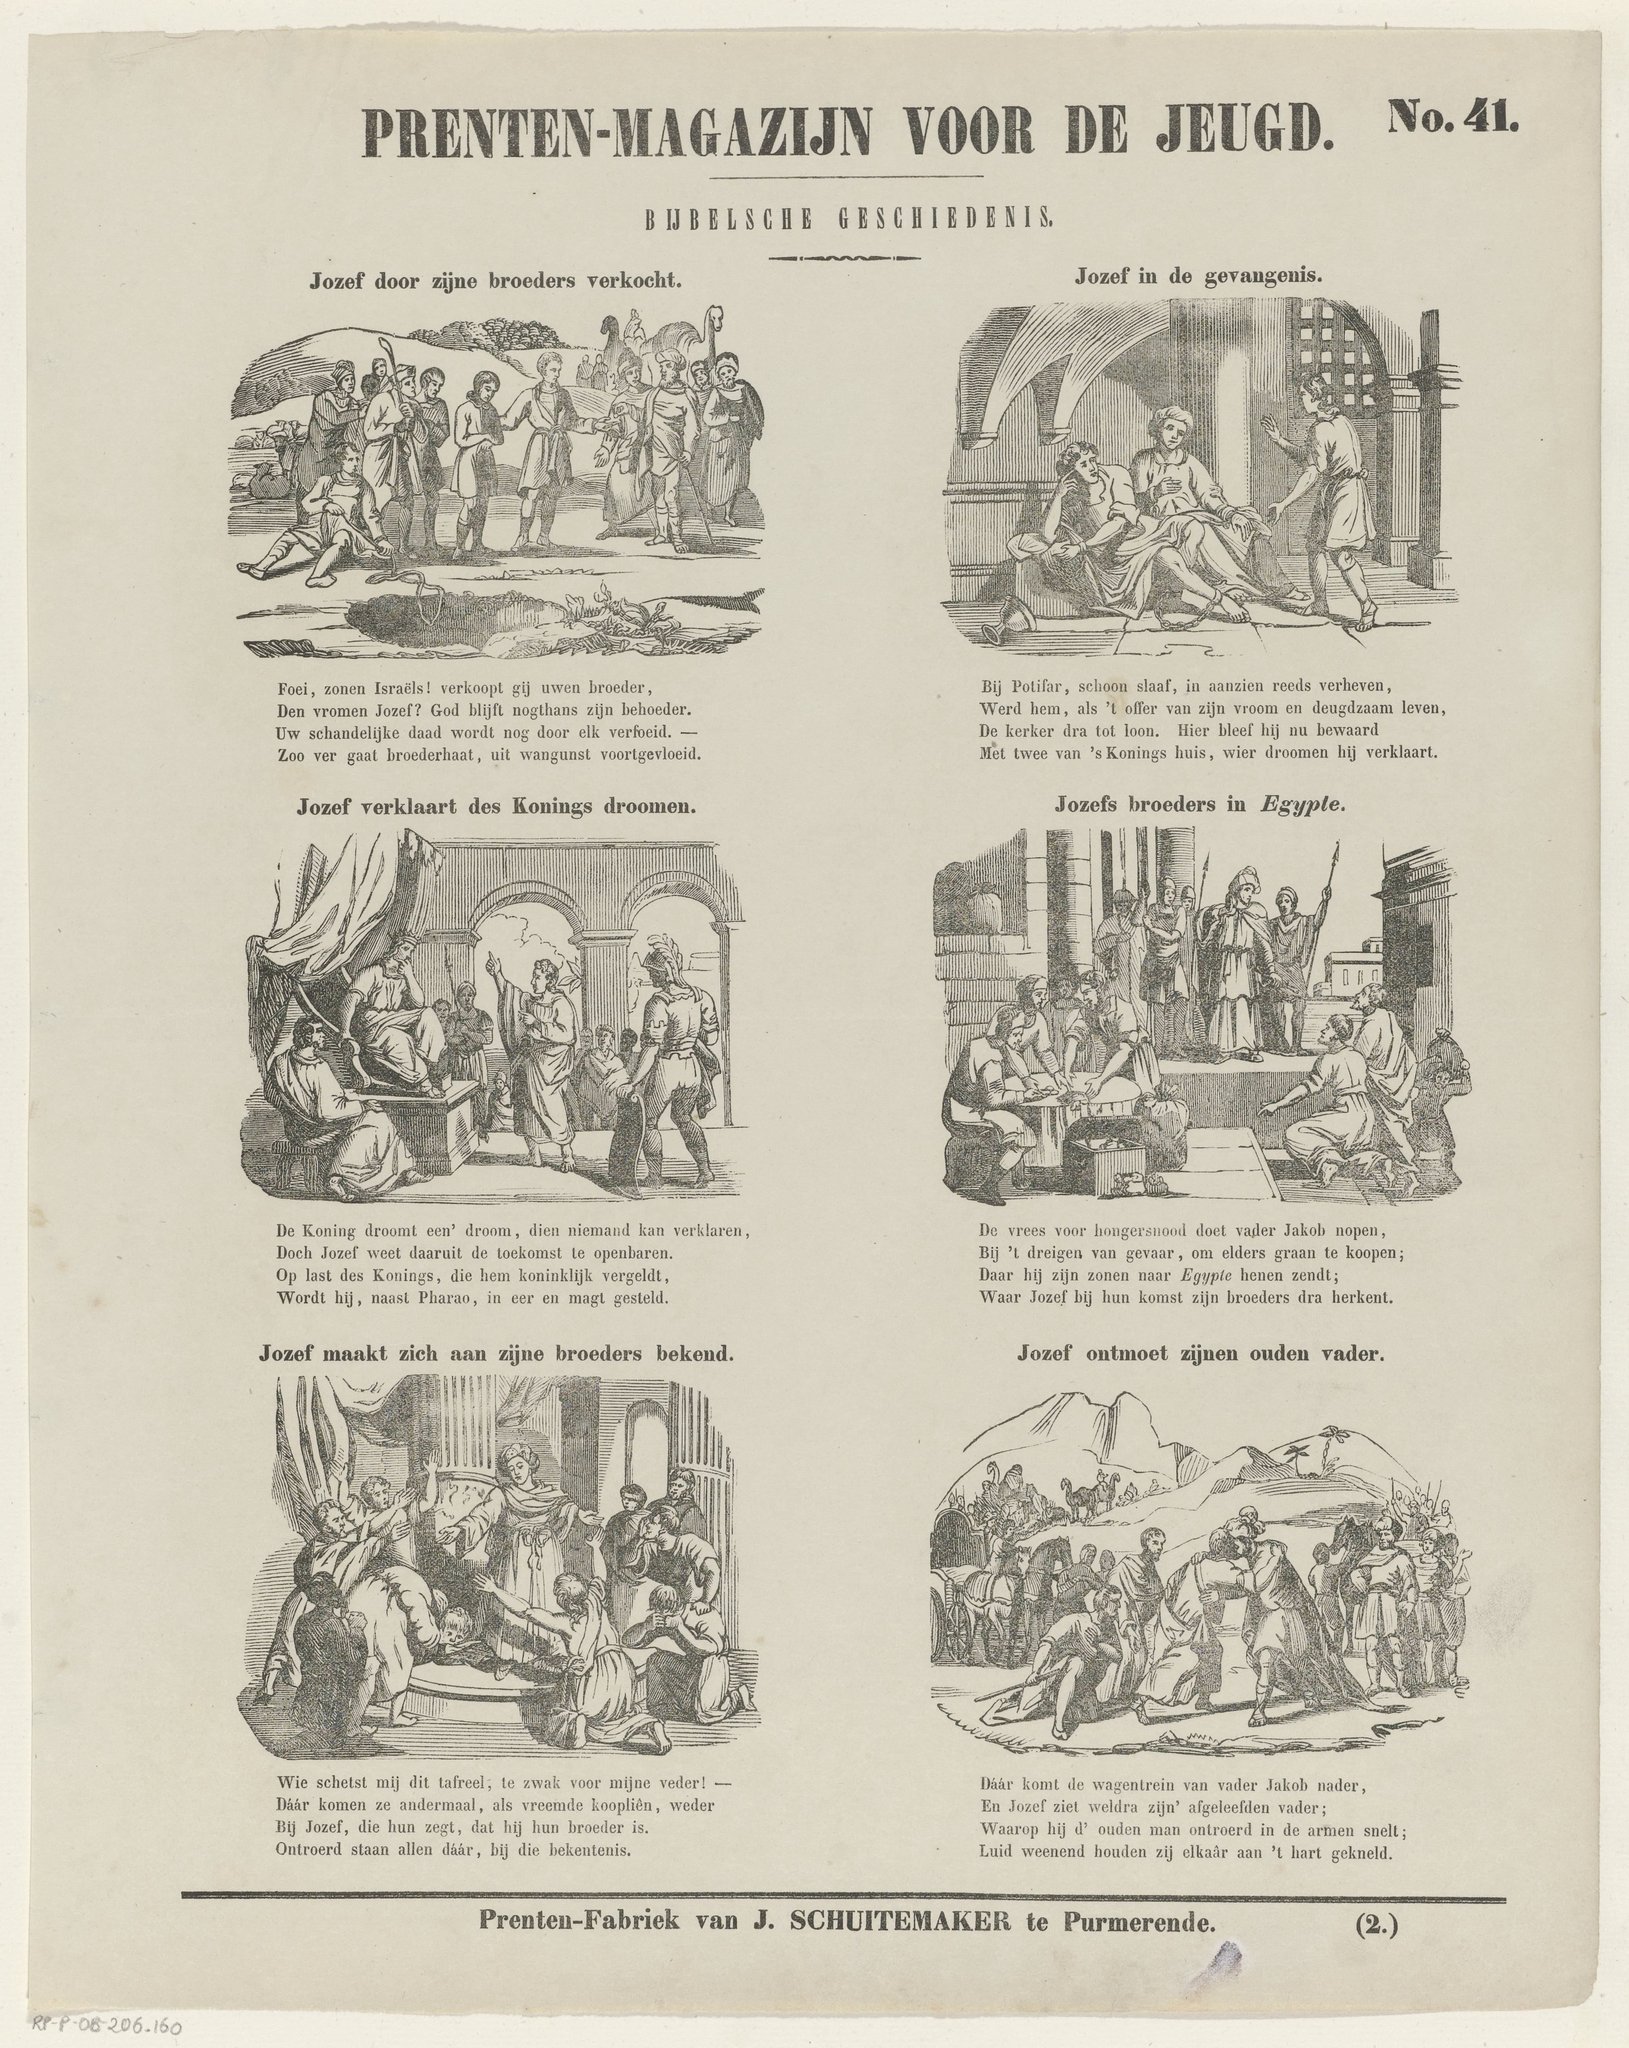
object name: print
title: Prenten-magazijn voor de jeugd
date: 1850-1881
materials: paper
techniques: letterpress printing, engraving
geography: leiden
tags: genesis: the story of joseph, old testament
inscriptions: collector's mark: Lugt 2760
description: Na voltooiing van de acht jaargangen van de reeks 'Prenten-magazijn voor de jeugd' in 1850 heeft Jan Schuitemaker al deze prenten heruitgegeven en omgenummerd als nr. 1 t/m 192. De oorspronkelijke jaargang wordt telkens nog vermeld rechtsonder op de prent. Binnen de jaargangen zijn prenten van hetzelfde thema in clusters van vier achter elkaar gezet.